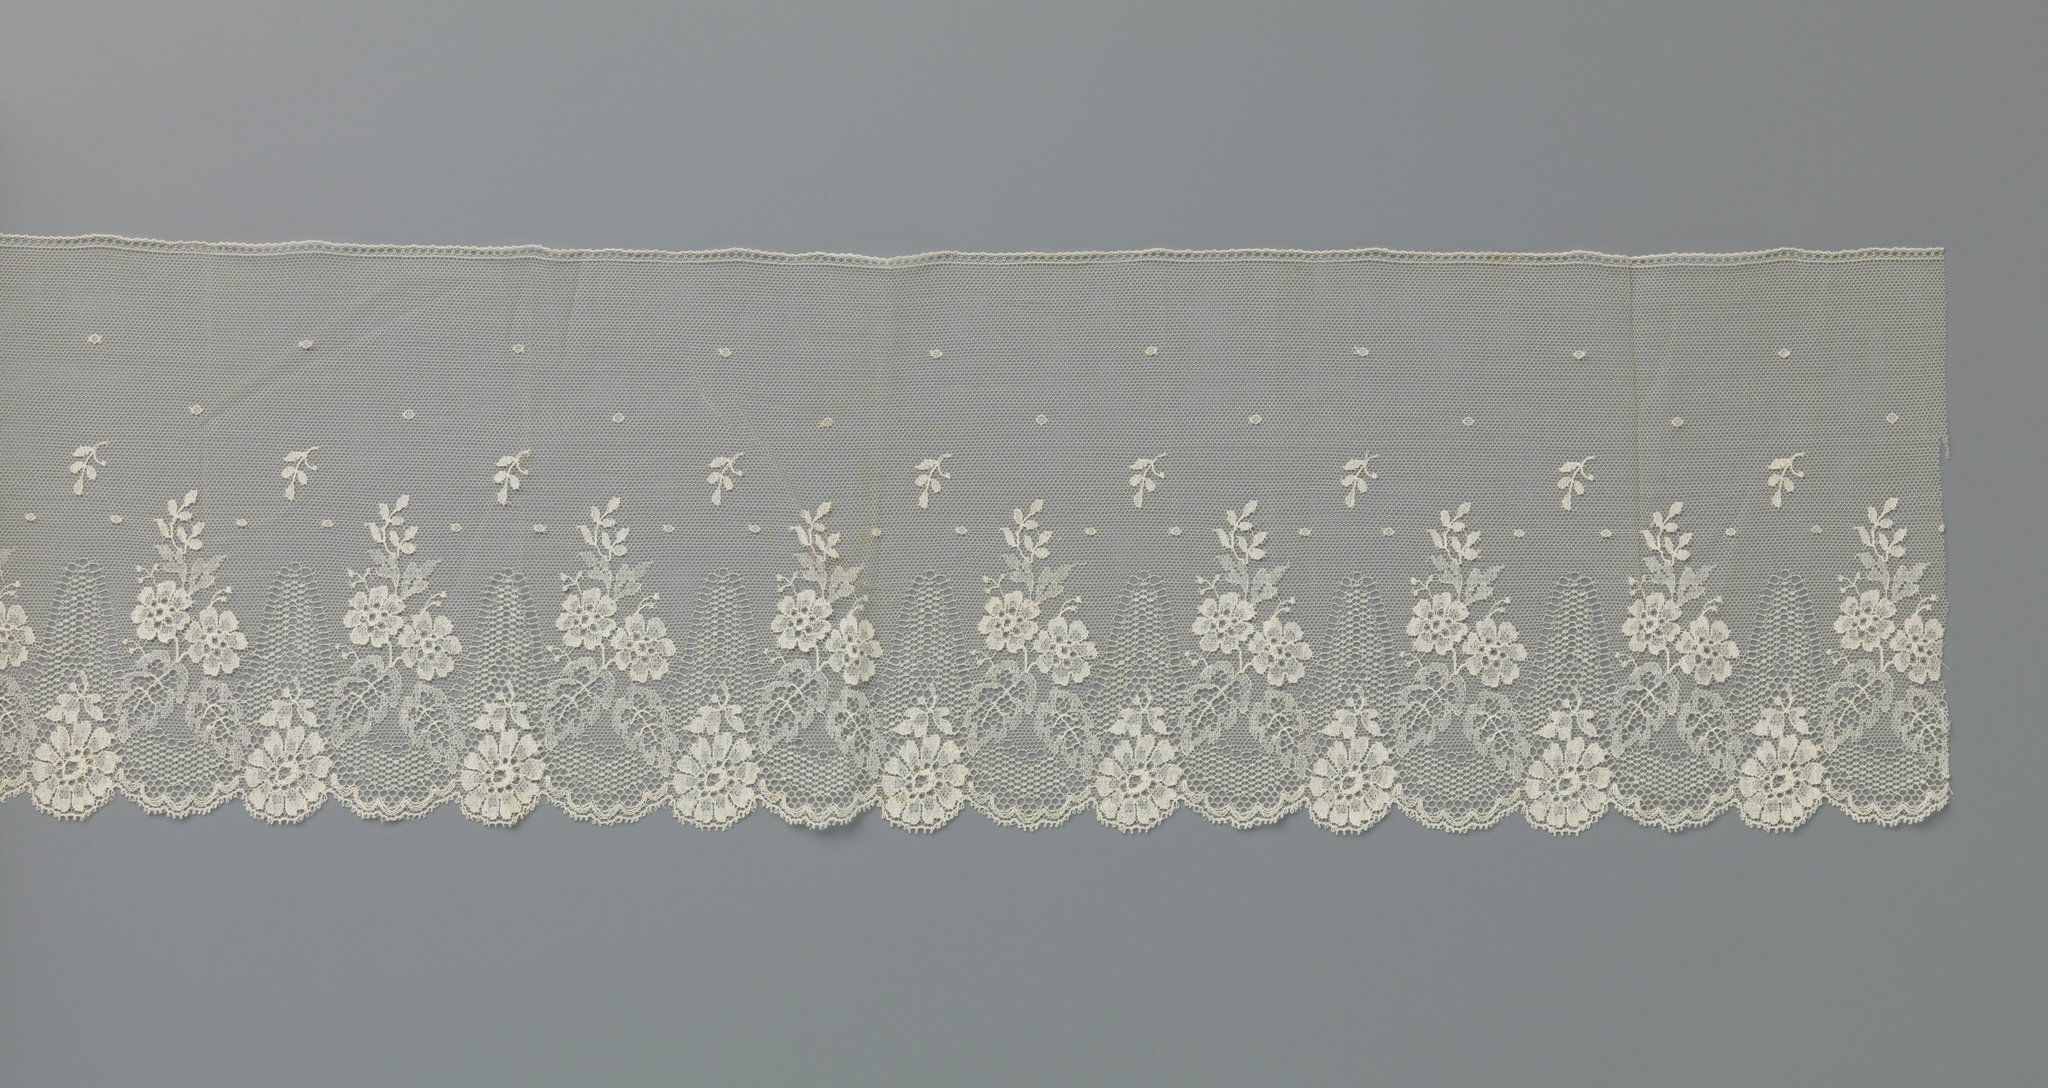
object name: strip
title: Strook machinale kant met aaneengeschakelde u-vormige velden met een bloemtakje erin en een hangende rozetbloem eronder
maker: Anonymous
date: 1800-1949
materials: cotton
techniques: lace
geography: western europe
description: Strook naturelkleurige machinale kant. Het zich herhalende patroon langs de onderste helft van de strook bestaat uit een aaneenschakeling van u-vormige motieven gemaakt met siergronden. Onder elke ‘poot’ van een u hangt een rozetbloem naar beneden. Deze bloem zorgt samen met de u-vormige velden voor een schulpenrand langs de onderzijde van de strook. In het u-vormige veld staat een bloemtak met twee kleinere rozetbloempjes. Tussen deze bloempjes steekt een takje met blaadjes omhoog. Onder de bloempjes hangen twee grotere bladeren. De bovenste helft van de strook heeft een wijd verspreid strooipatroon van moesjes waartussen één rij hangende bladertakjes. De motieven zijn deels voorzien van contourdraden en zijn met elkaar verbonden door een fijne machinale tulegrond. Een smal randje langs de bovenzijde is gemaakt in machinale rozenslag. De schulpenrand langs de onderzijde van de strook is afgewerkt met picots.